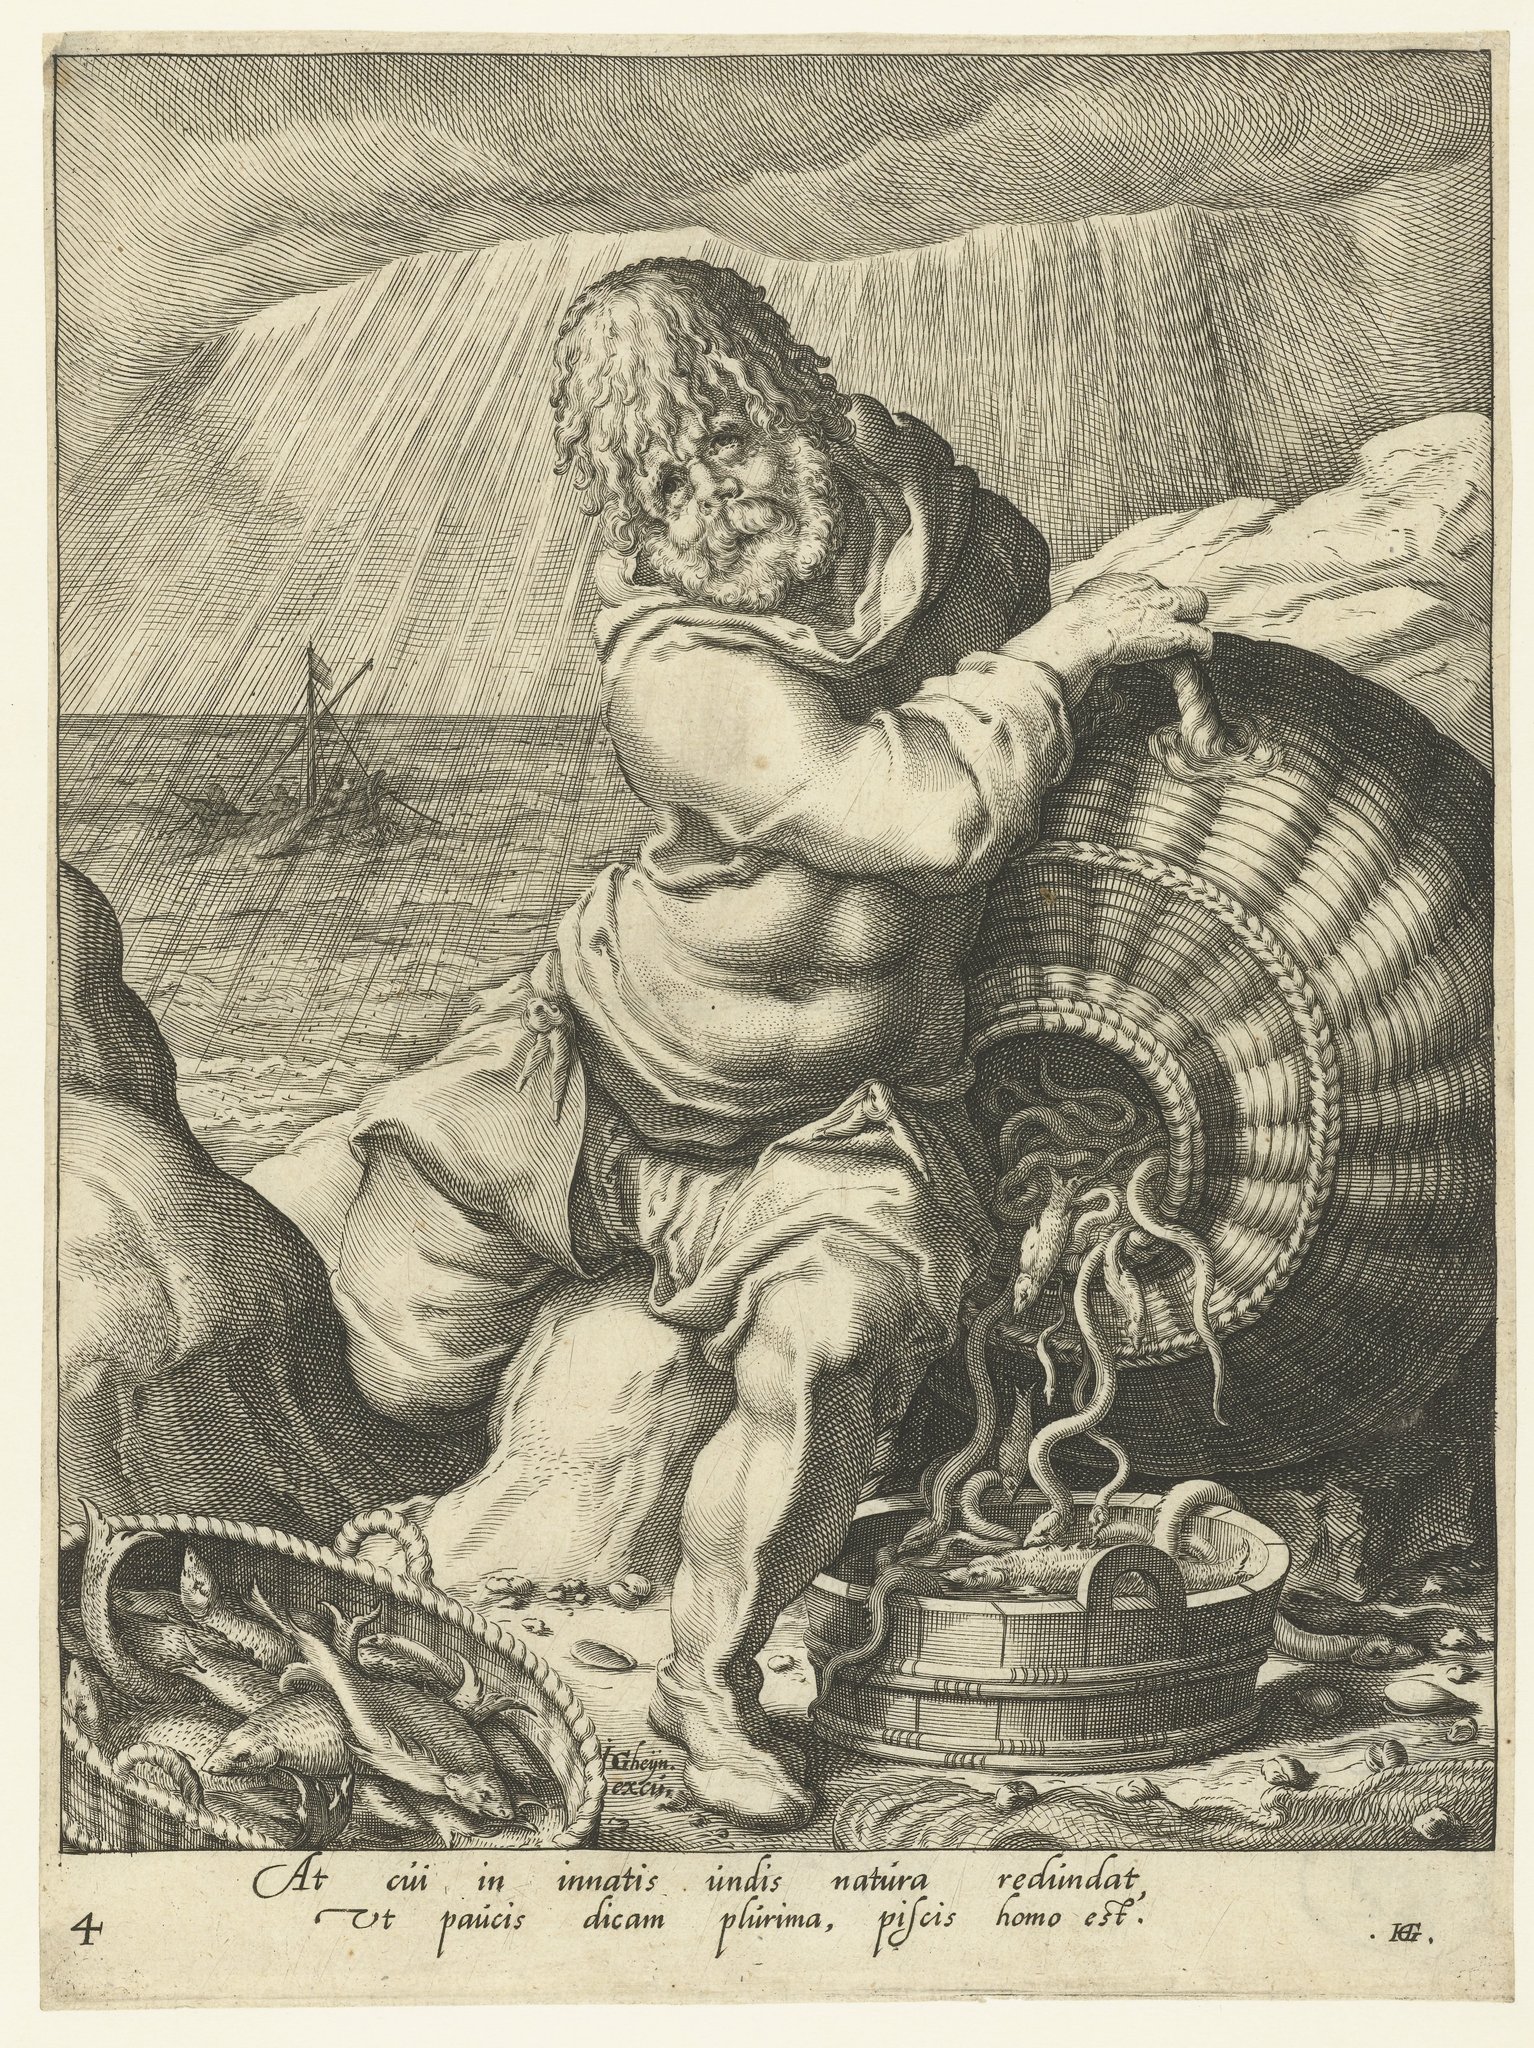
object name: print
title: De vier temperamenten (verbonden met de vier elementen)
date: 1596-1597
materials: paper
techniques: engraving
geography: netherlands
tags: commercial fishery, water (one of the four elements), phlegmatic temperament, fisherman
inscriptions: collector's mark: Lugt 2228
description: Voorstelling van het flegmatische temperament in de vorm van een oude man gekleed in lieslaarzen (een visser), gezeten aan een strand en omringd door een korf, een mand en een houten bak vol vis. Op de achtergrond een vissersboot op het water. Onder de voorstelling twee regels tekst in Latijn. Deze prent is onderdeel van een serie van de vier temperamenten, elk verbeeld door een figuur ten voeten uit, verwikkeld in een handeling en zittend/staand in een omgeving die geassocieerd wordt met een van de vier elementen. Elke voorstelling heeft een tweeregelig Latijns onderschrift.